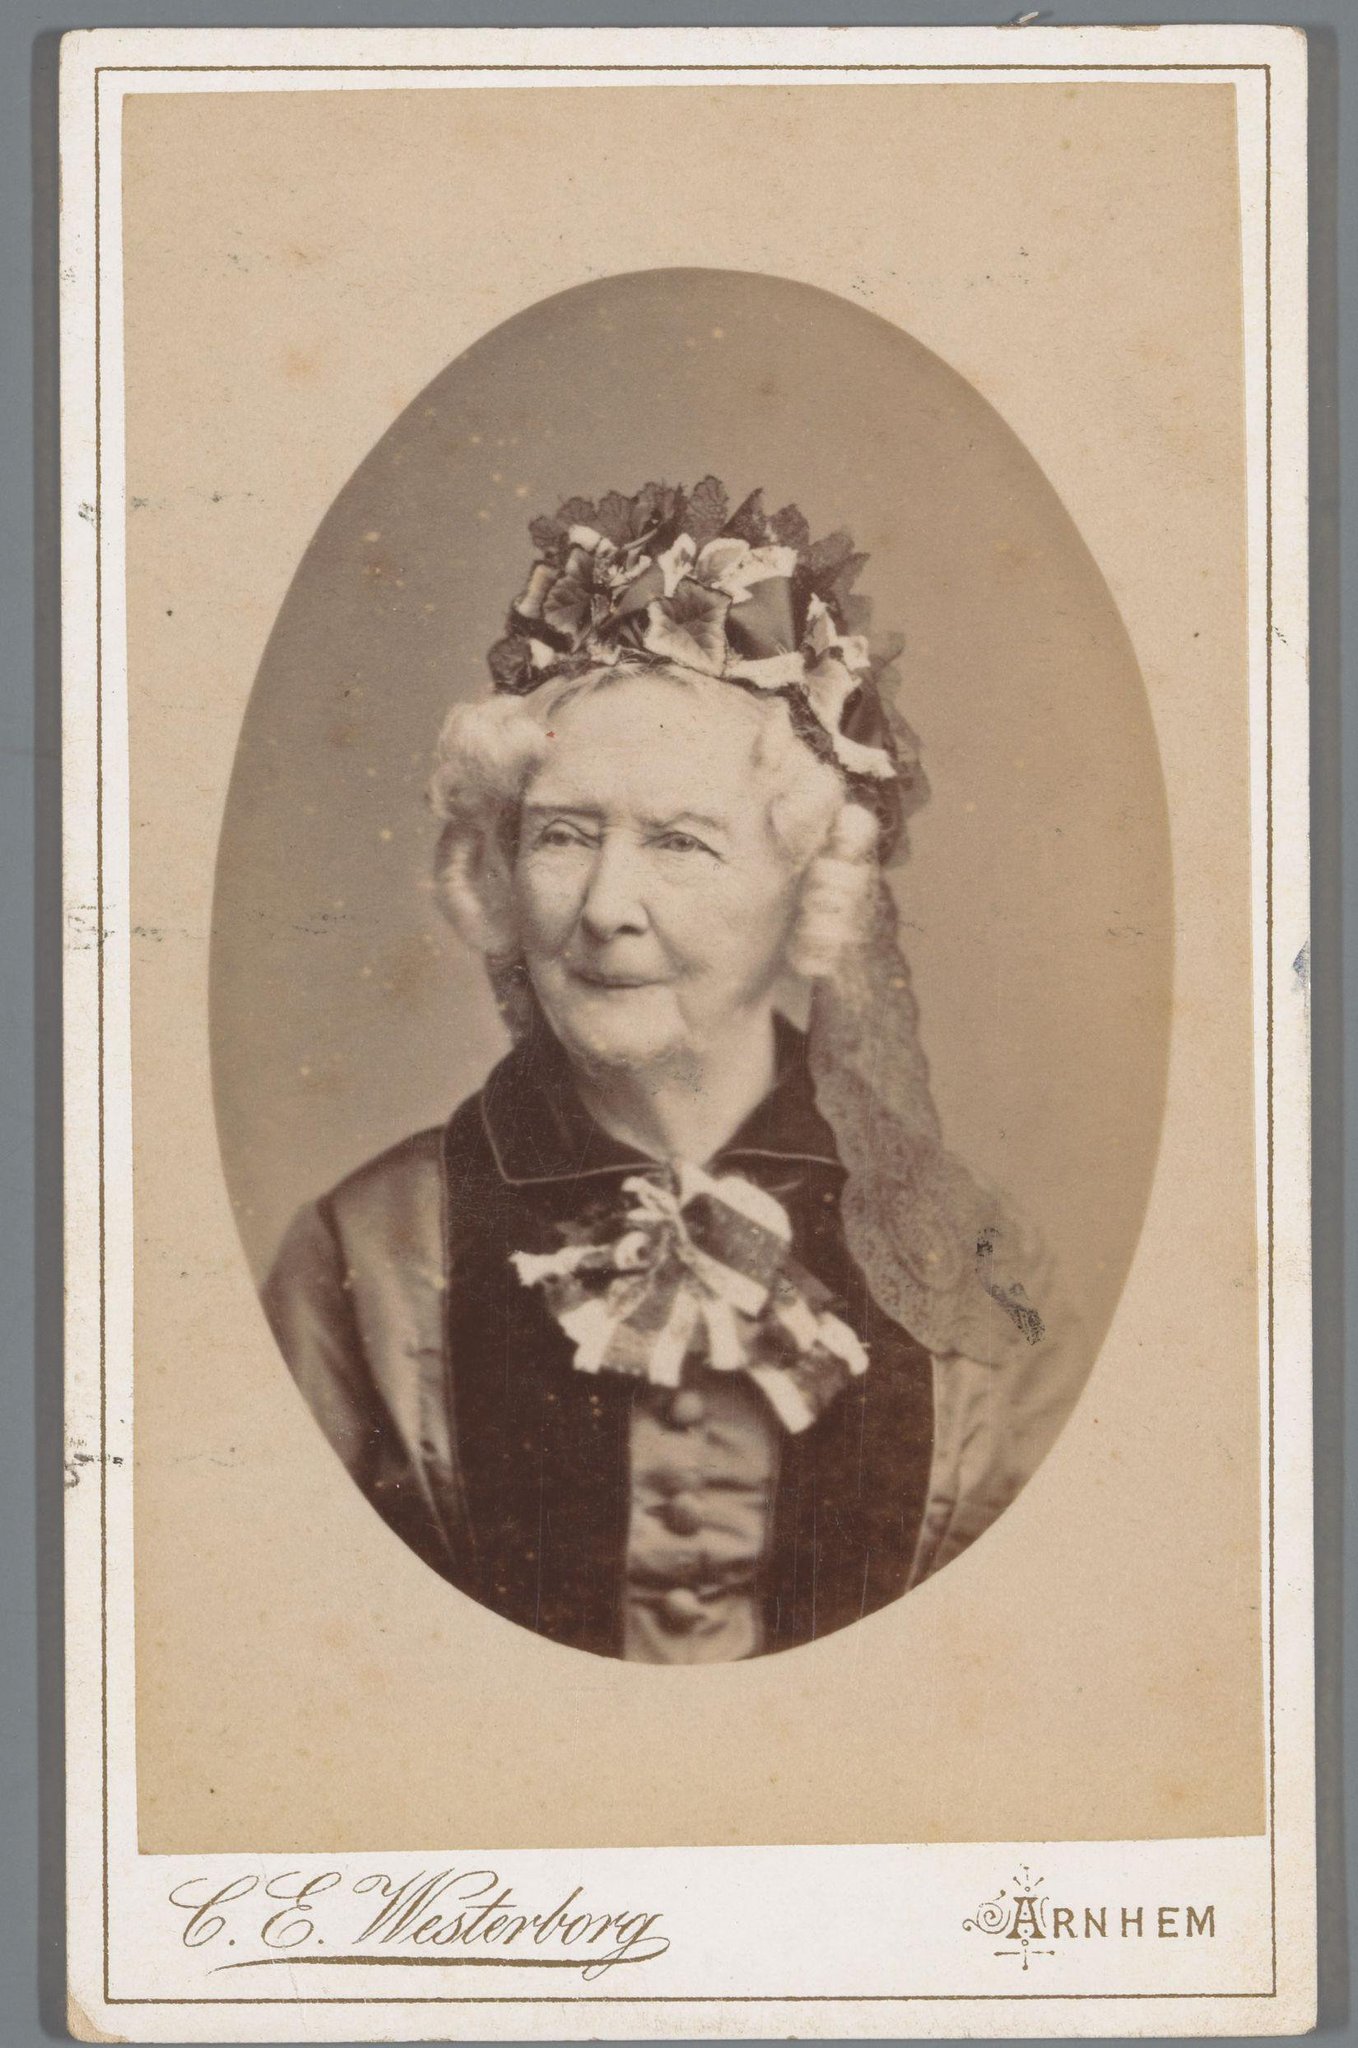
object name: photograph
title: Portret van een onbekende oude vrouw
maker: carel eduard westerborg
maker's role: fotograaf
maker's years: 1842-1916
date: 1861-1915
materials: cardboard, paper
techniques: albumen print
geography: arnhem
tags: old woman, anonymous historical person portrayed, arnhem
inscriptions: monogram: ‘CEW’, inscription: ‘C.E. Westerborg/ Photographisch Atelier/ Arnhem/ Eusebius Buiten Singel No.1, Hoek Spijkerstraat./ De platen worden voor nabestelling bewaard./ Musterschutz A.L.’, inscription: ‘C.E. Westerborg Arnhem’